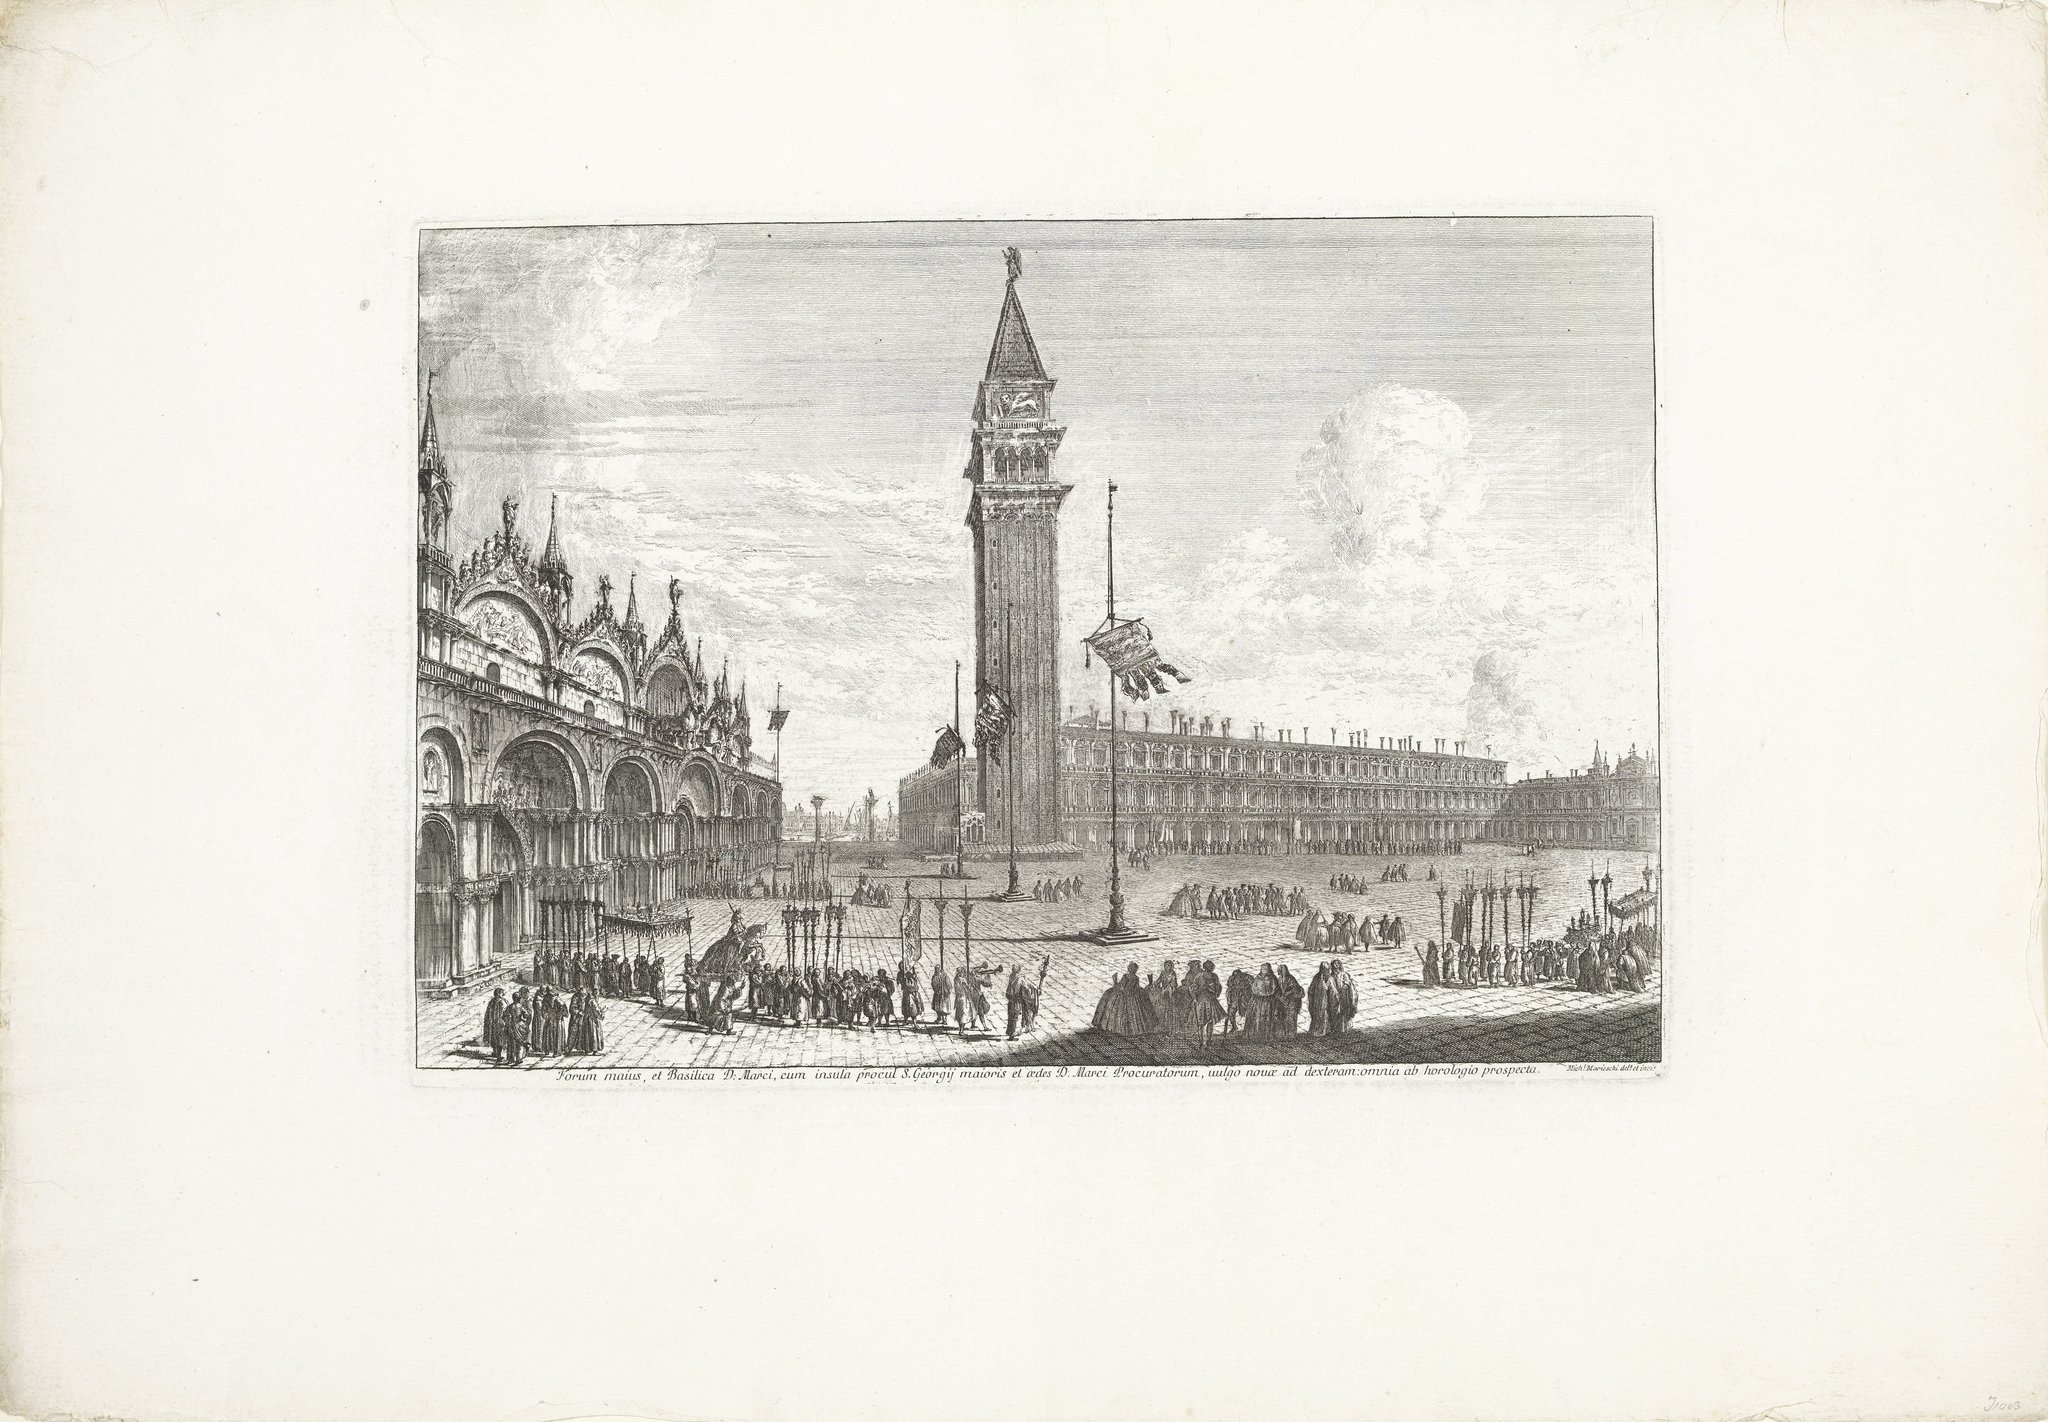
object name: print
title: Forum maius, et Basilica D: Marci, cum insula procul S. Georgij Maioris et aedes D: Marci Procatorum (...)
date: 1741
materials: paper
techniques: engraving, etching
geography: venice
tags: square, place, circus, etc., city-view, and landscape with man-made constructions, church (exterior), venice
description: Gezicht op het Piazza San Marco te Venetië. Links de San Marco. Over het plein lopen geestelijken in een processie.